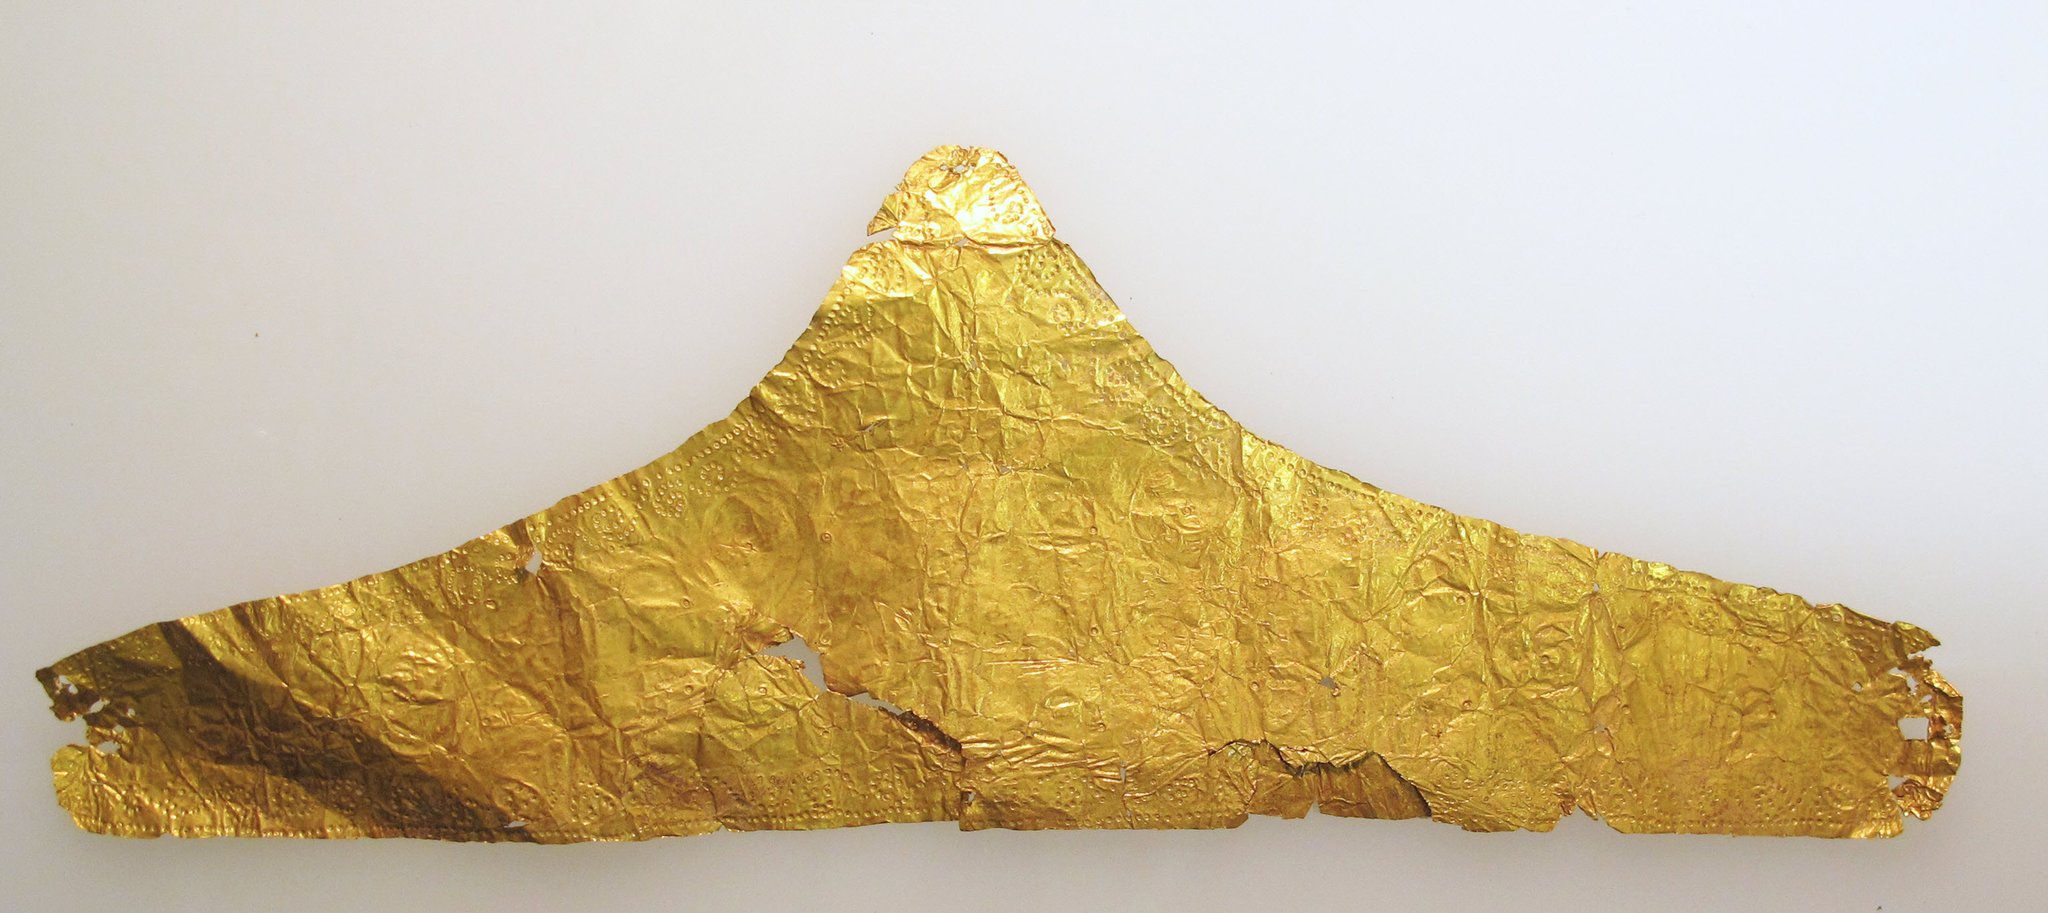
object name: frontlet of gold leaf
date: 7000 BCE-330 CE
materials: gold